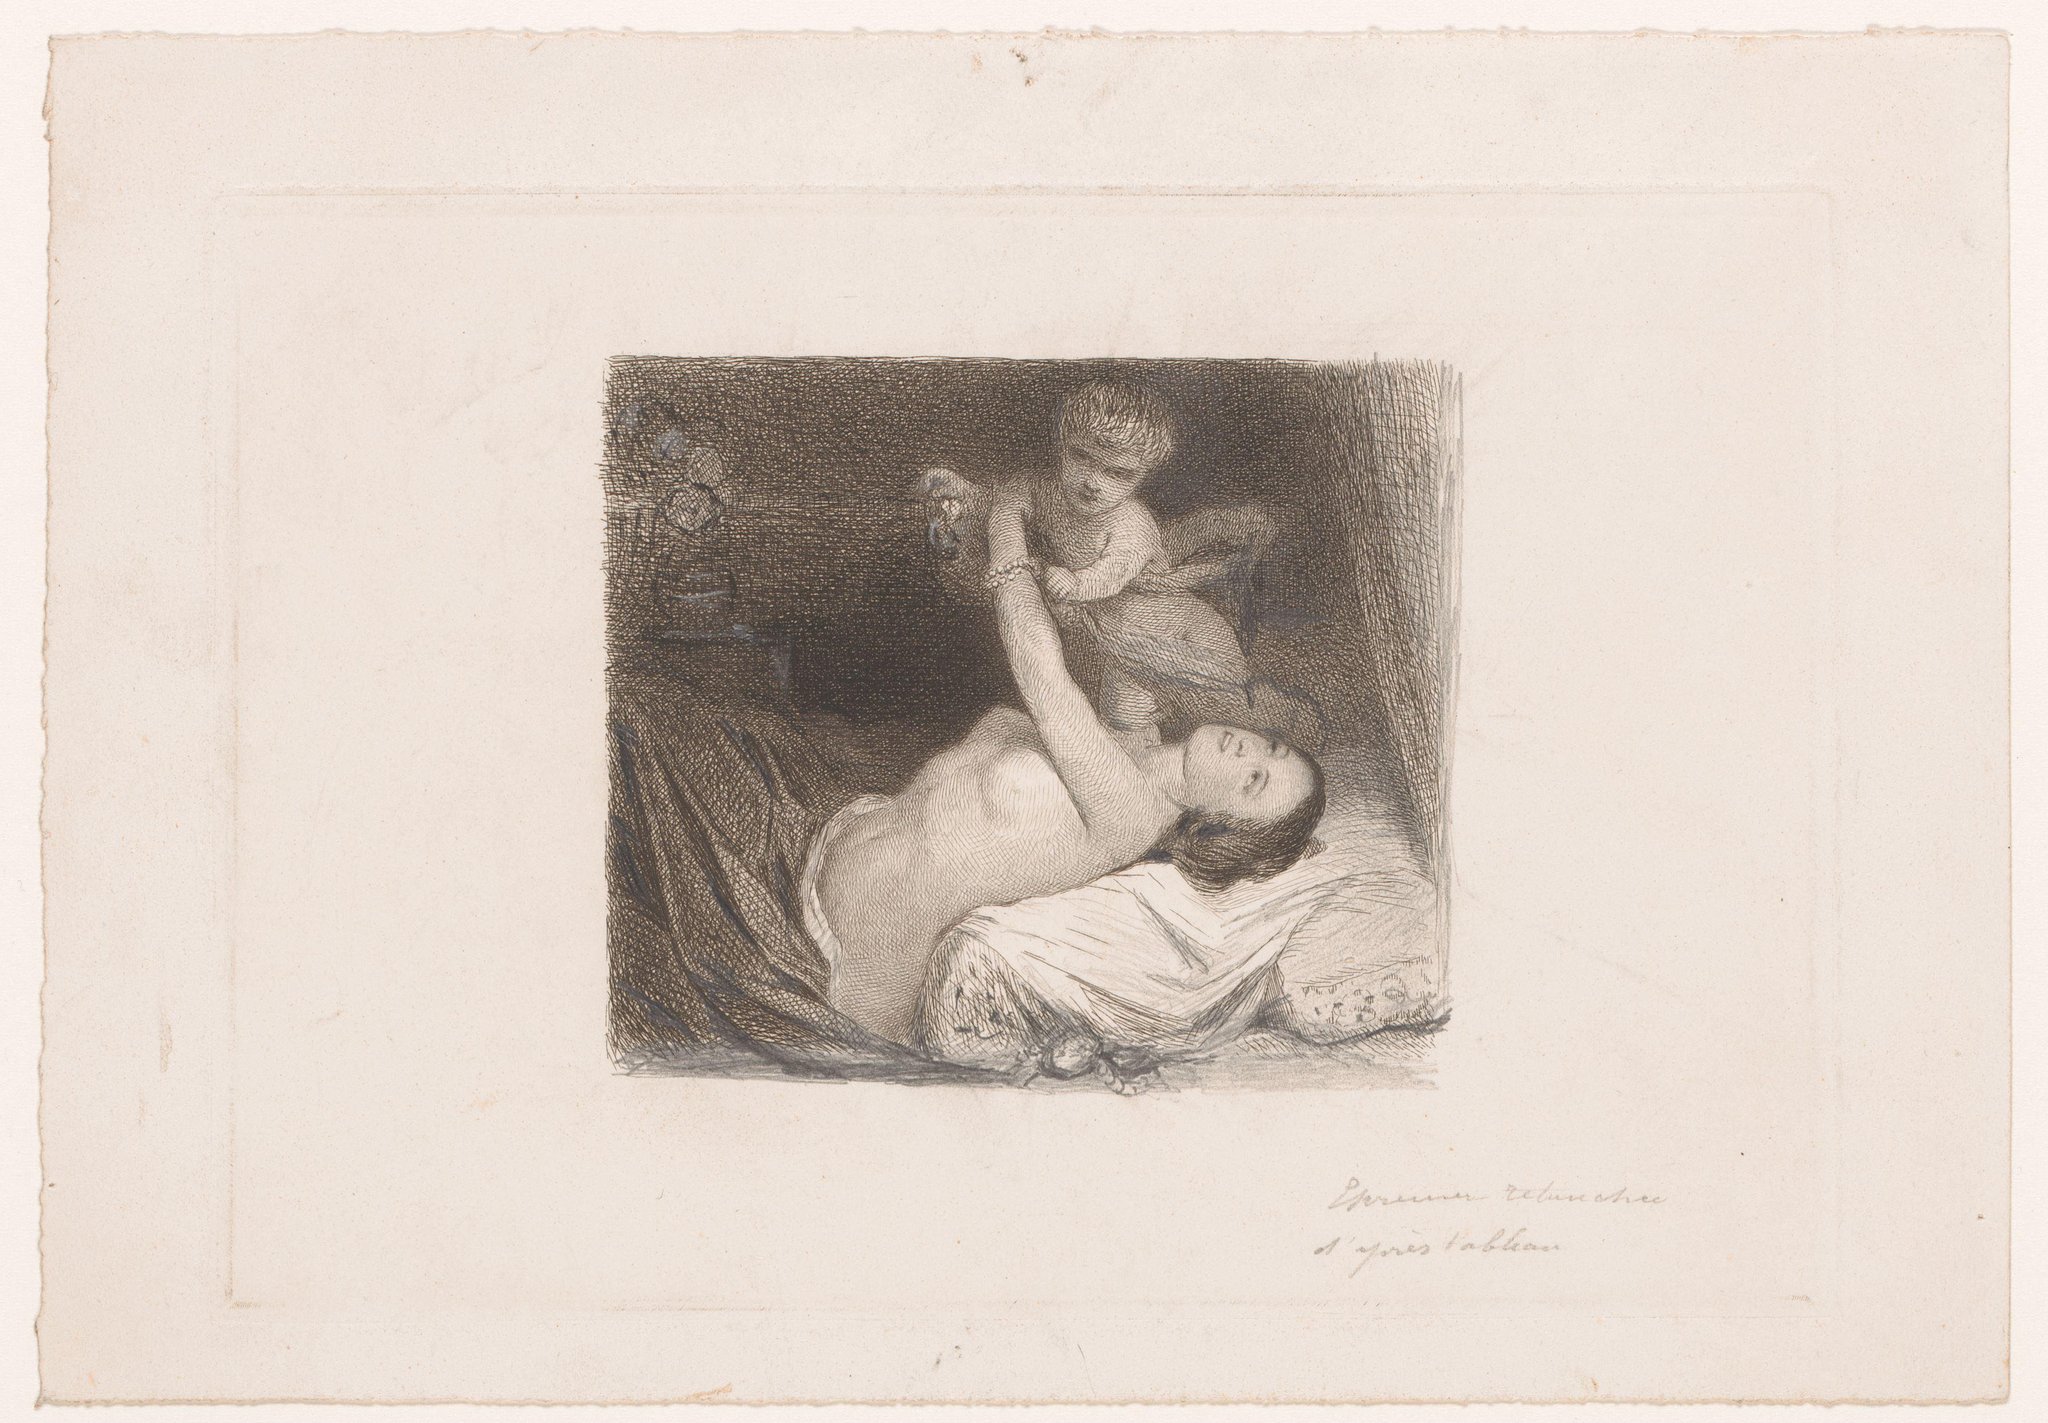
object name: print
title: Jonge vrouw en kind op bed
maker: jean baptiste pierre michiels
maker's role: print maker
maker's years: 1821-1890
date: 1831-1890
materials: chalk, paper, pencil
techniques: etching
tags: adolescent, young woman, maiden, mother and baby or young child, the (nude) human figure; 'corpo humano' (ripa) - aa - female human figure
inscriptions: collector's mark: Lugt 2228, inscription: ‘Epreuve retouchee d'apres tableau’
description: Mogelijk gaat het om een voorstelling van Amor en Psyche.